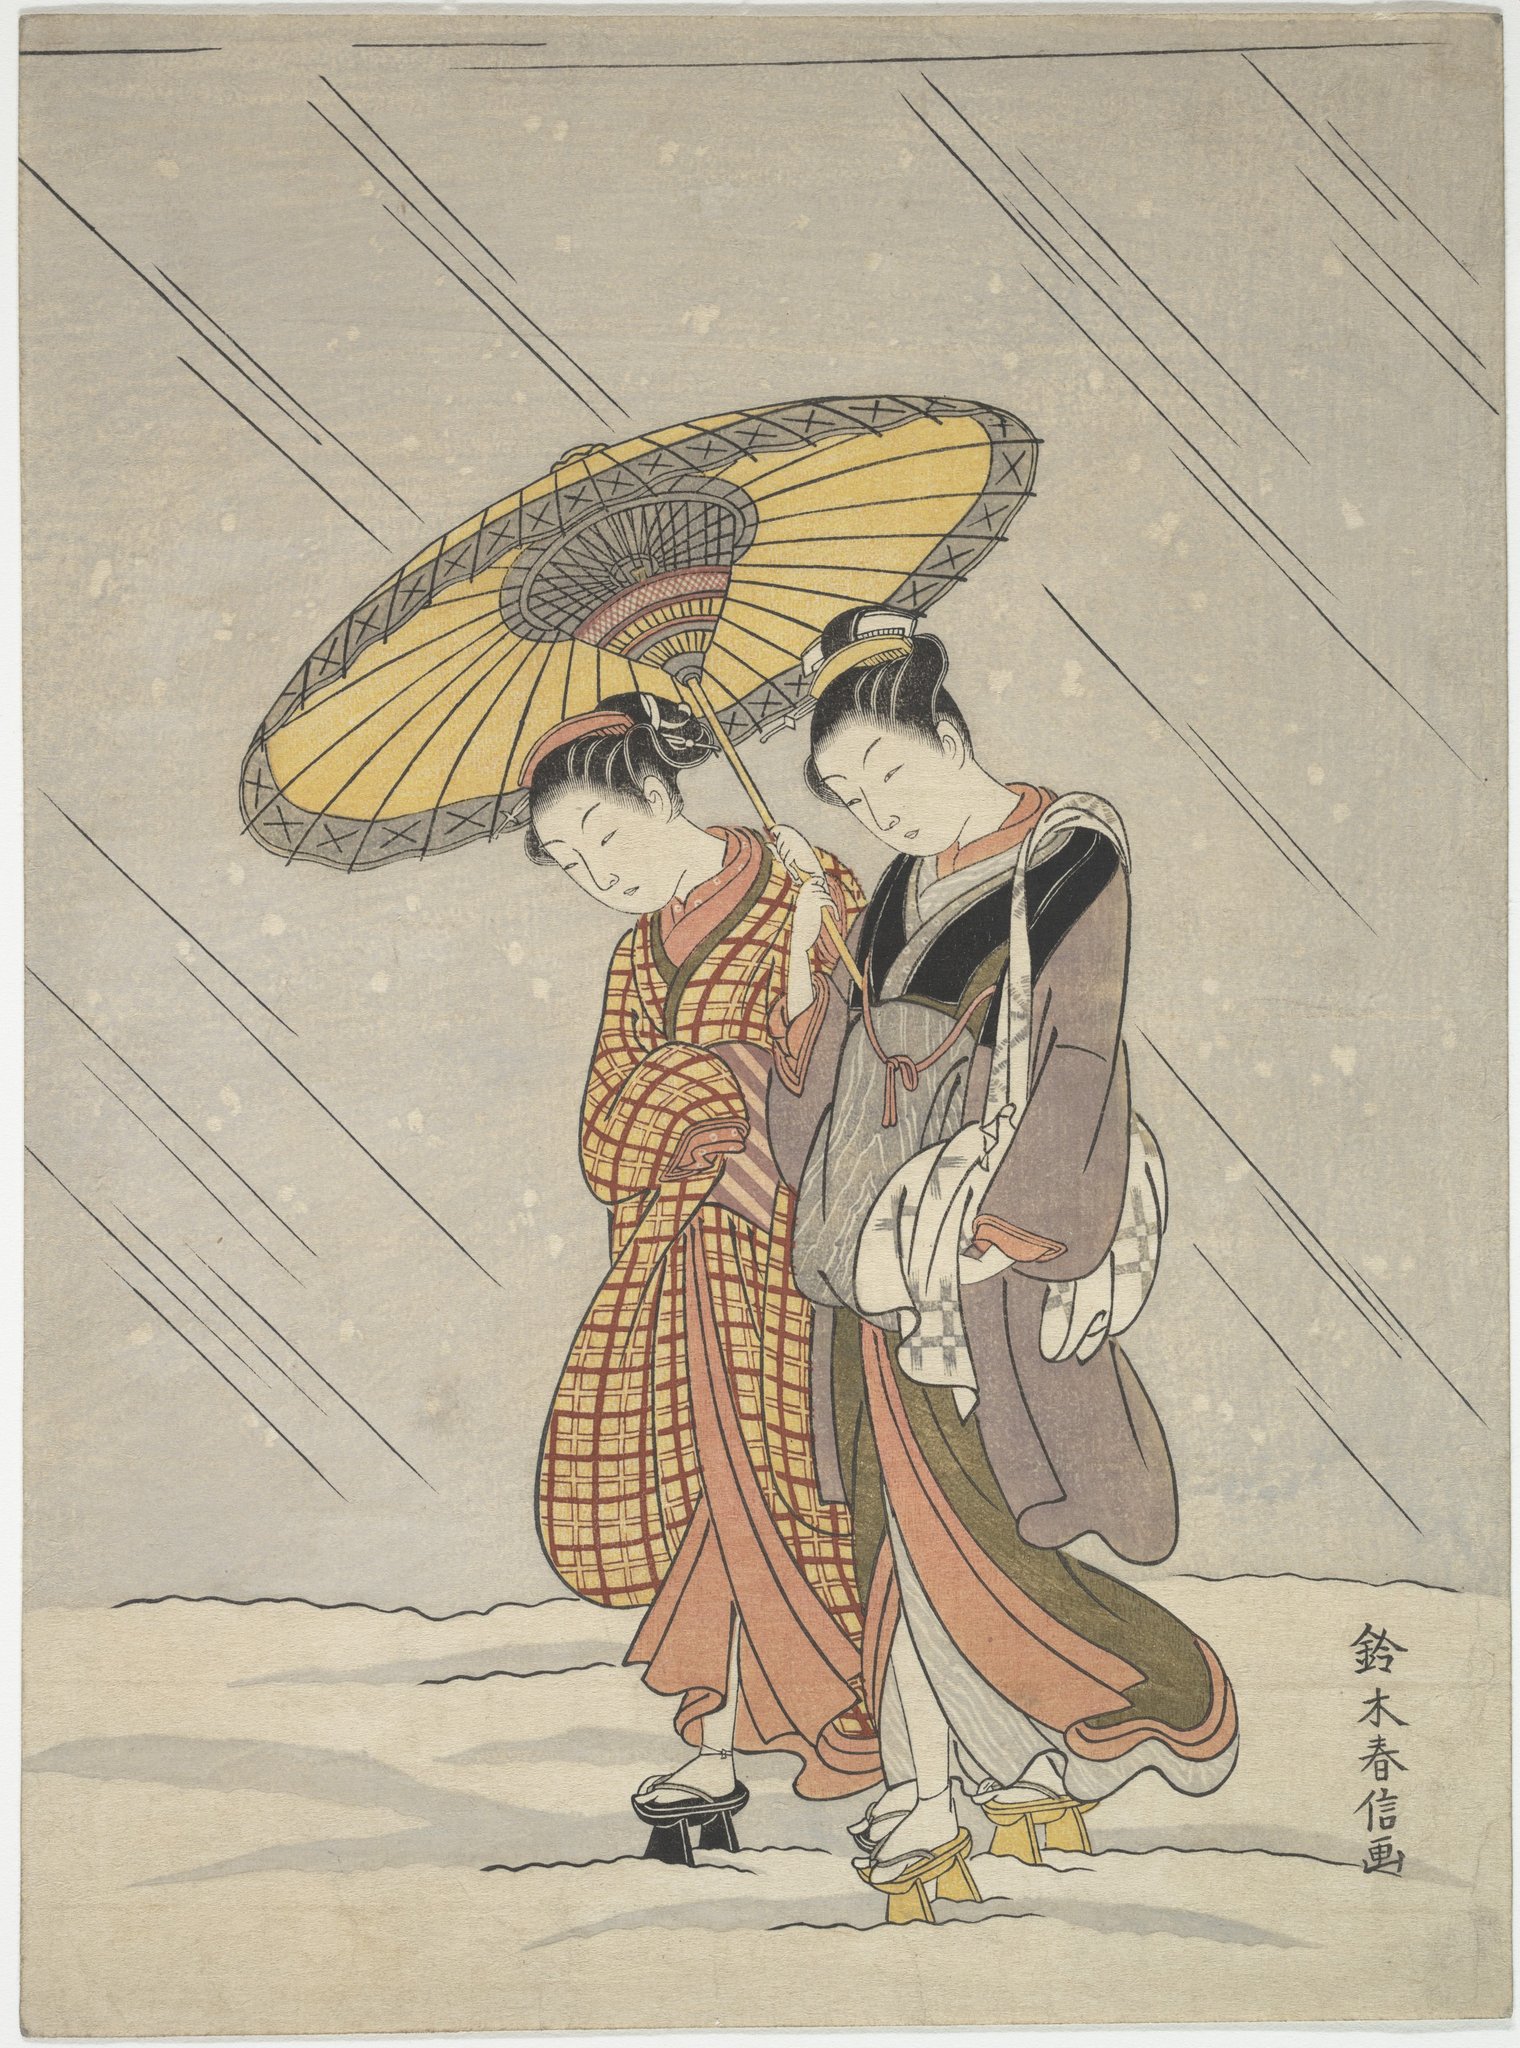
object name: print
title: Two Women in a Storm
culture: japanese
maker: suzuki harunobu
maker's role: artist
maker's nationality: japanese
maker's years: 1725-1770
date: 1764-1772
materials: ink, paper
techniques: woodblock print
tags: women,rain,umbrellas